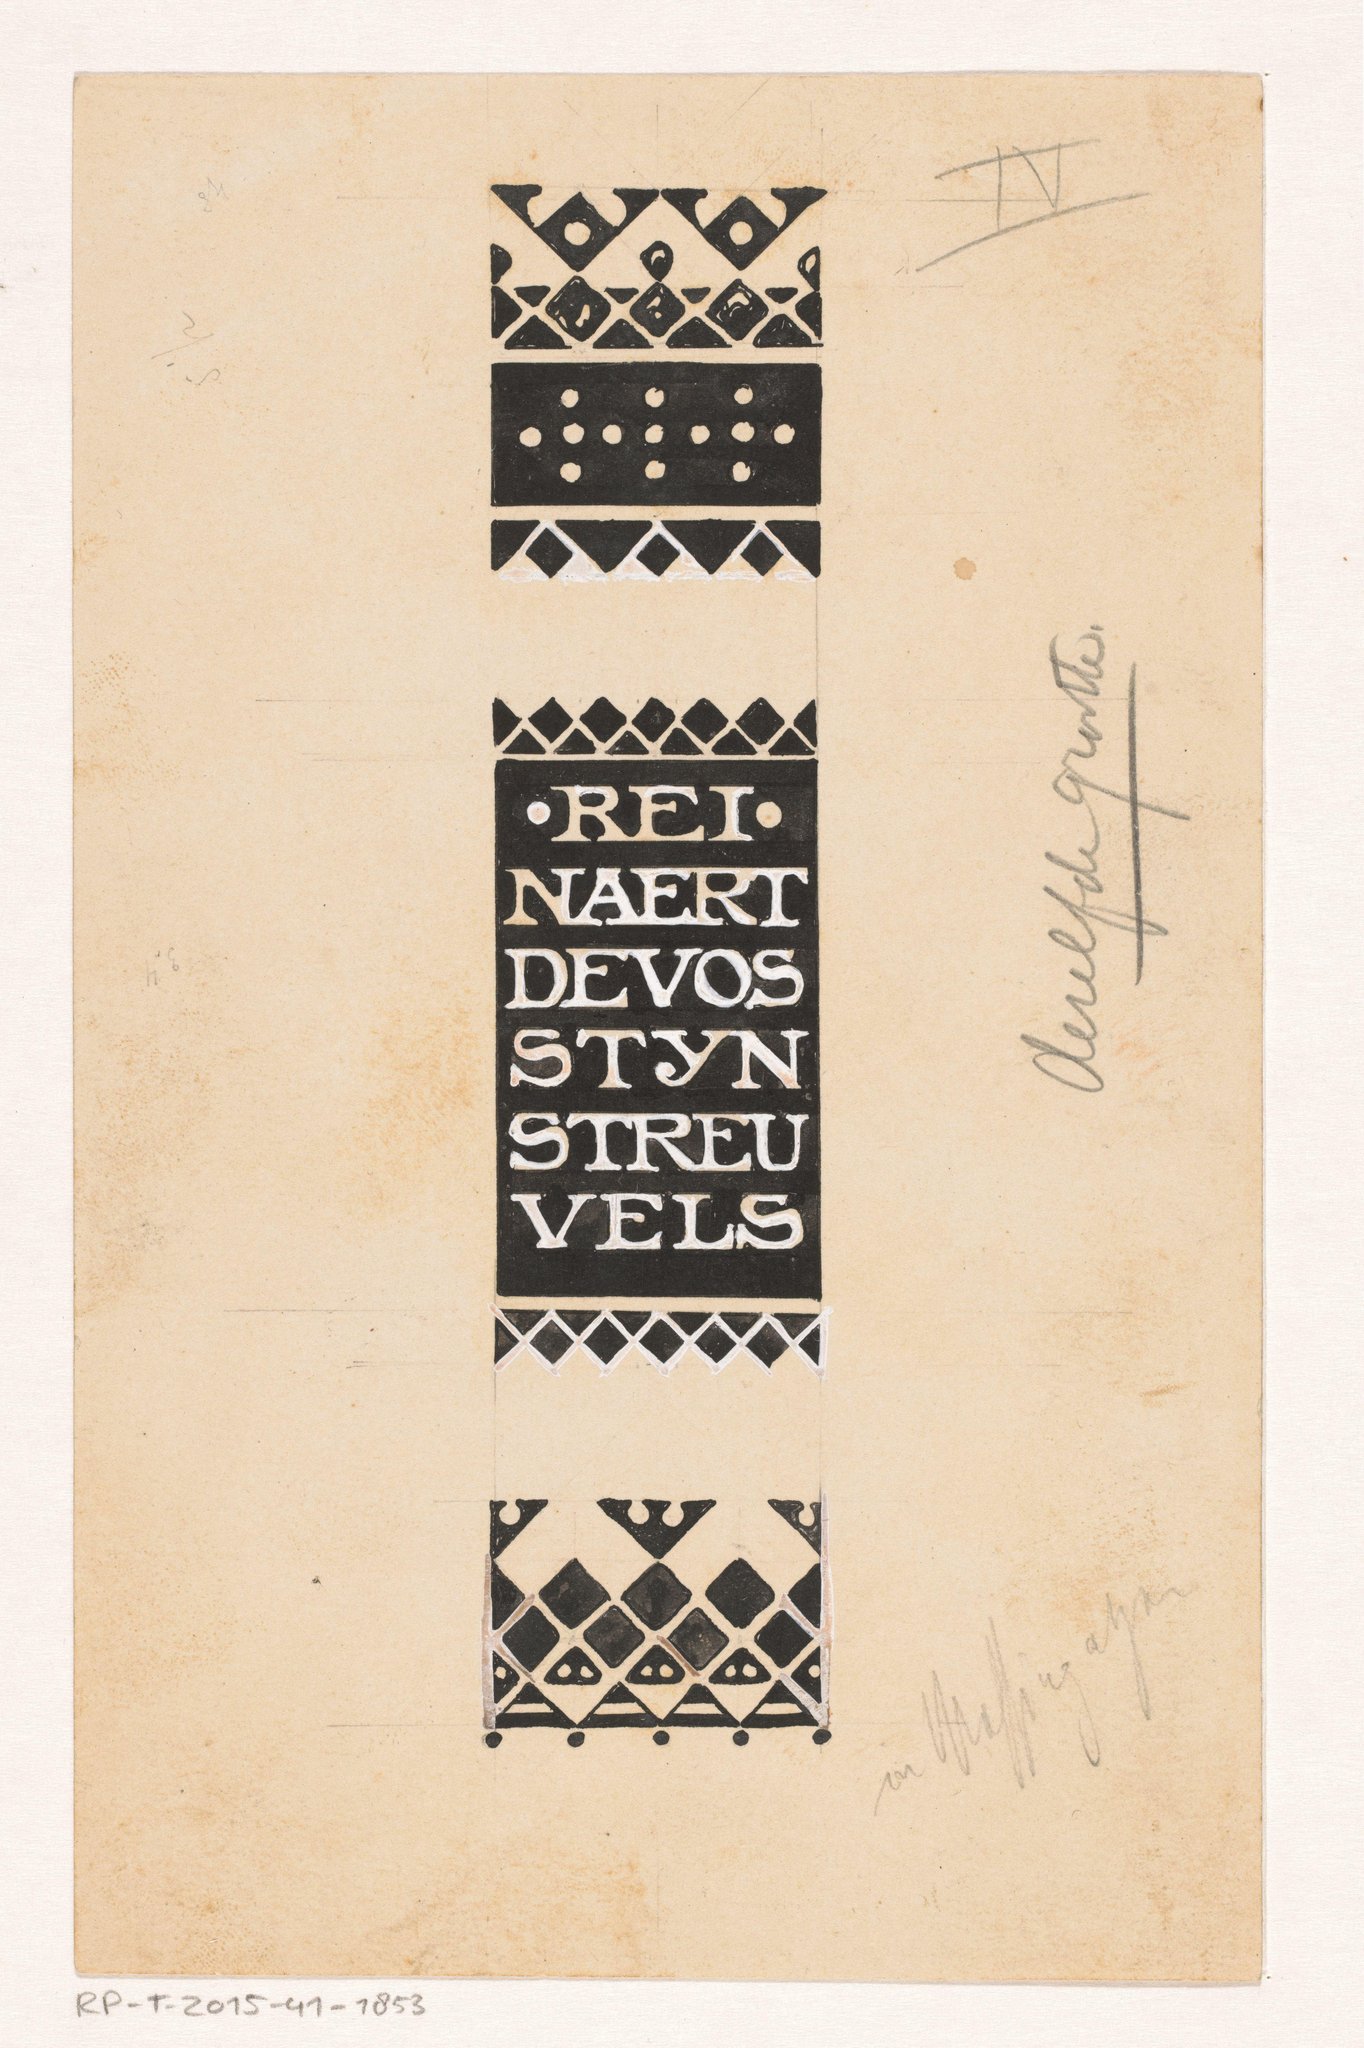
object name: boekrug ontwerp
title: Ontwerp voor een boekrug voor: Stijn Streuvels, Reinaert de Vos, 1910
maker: bernard willem wierink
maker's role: draughtsman, print maker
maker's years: 1856-1939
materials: paint, ink, paper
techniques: brush, pen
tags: ornament ~ geometric motifs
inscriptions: collector's mark: Lugt 2228, :, number: ‘IV’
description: Ontwerp voor een boekrug met boven en onder de boektitel patronen met geometrische vormen.